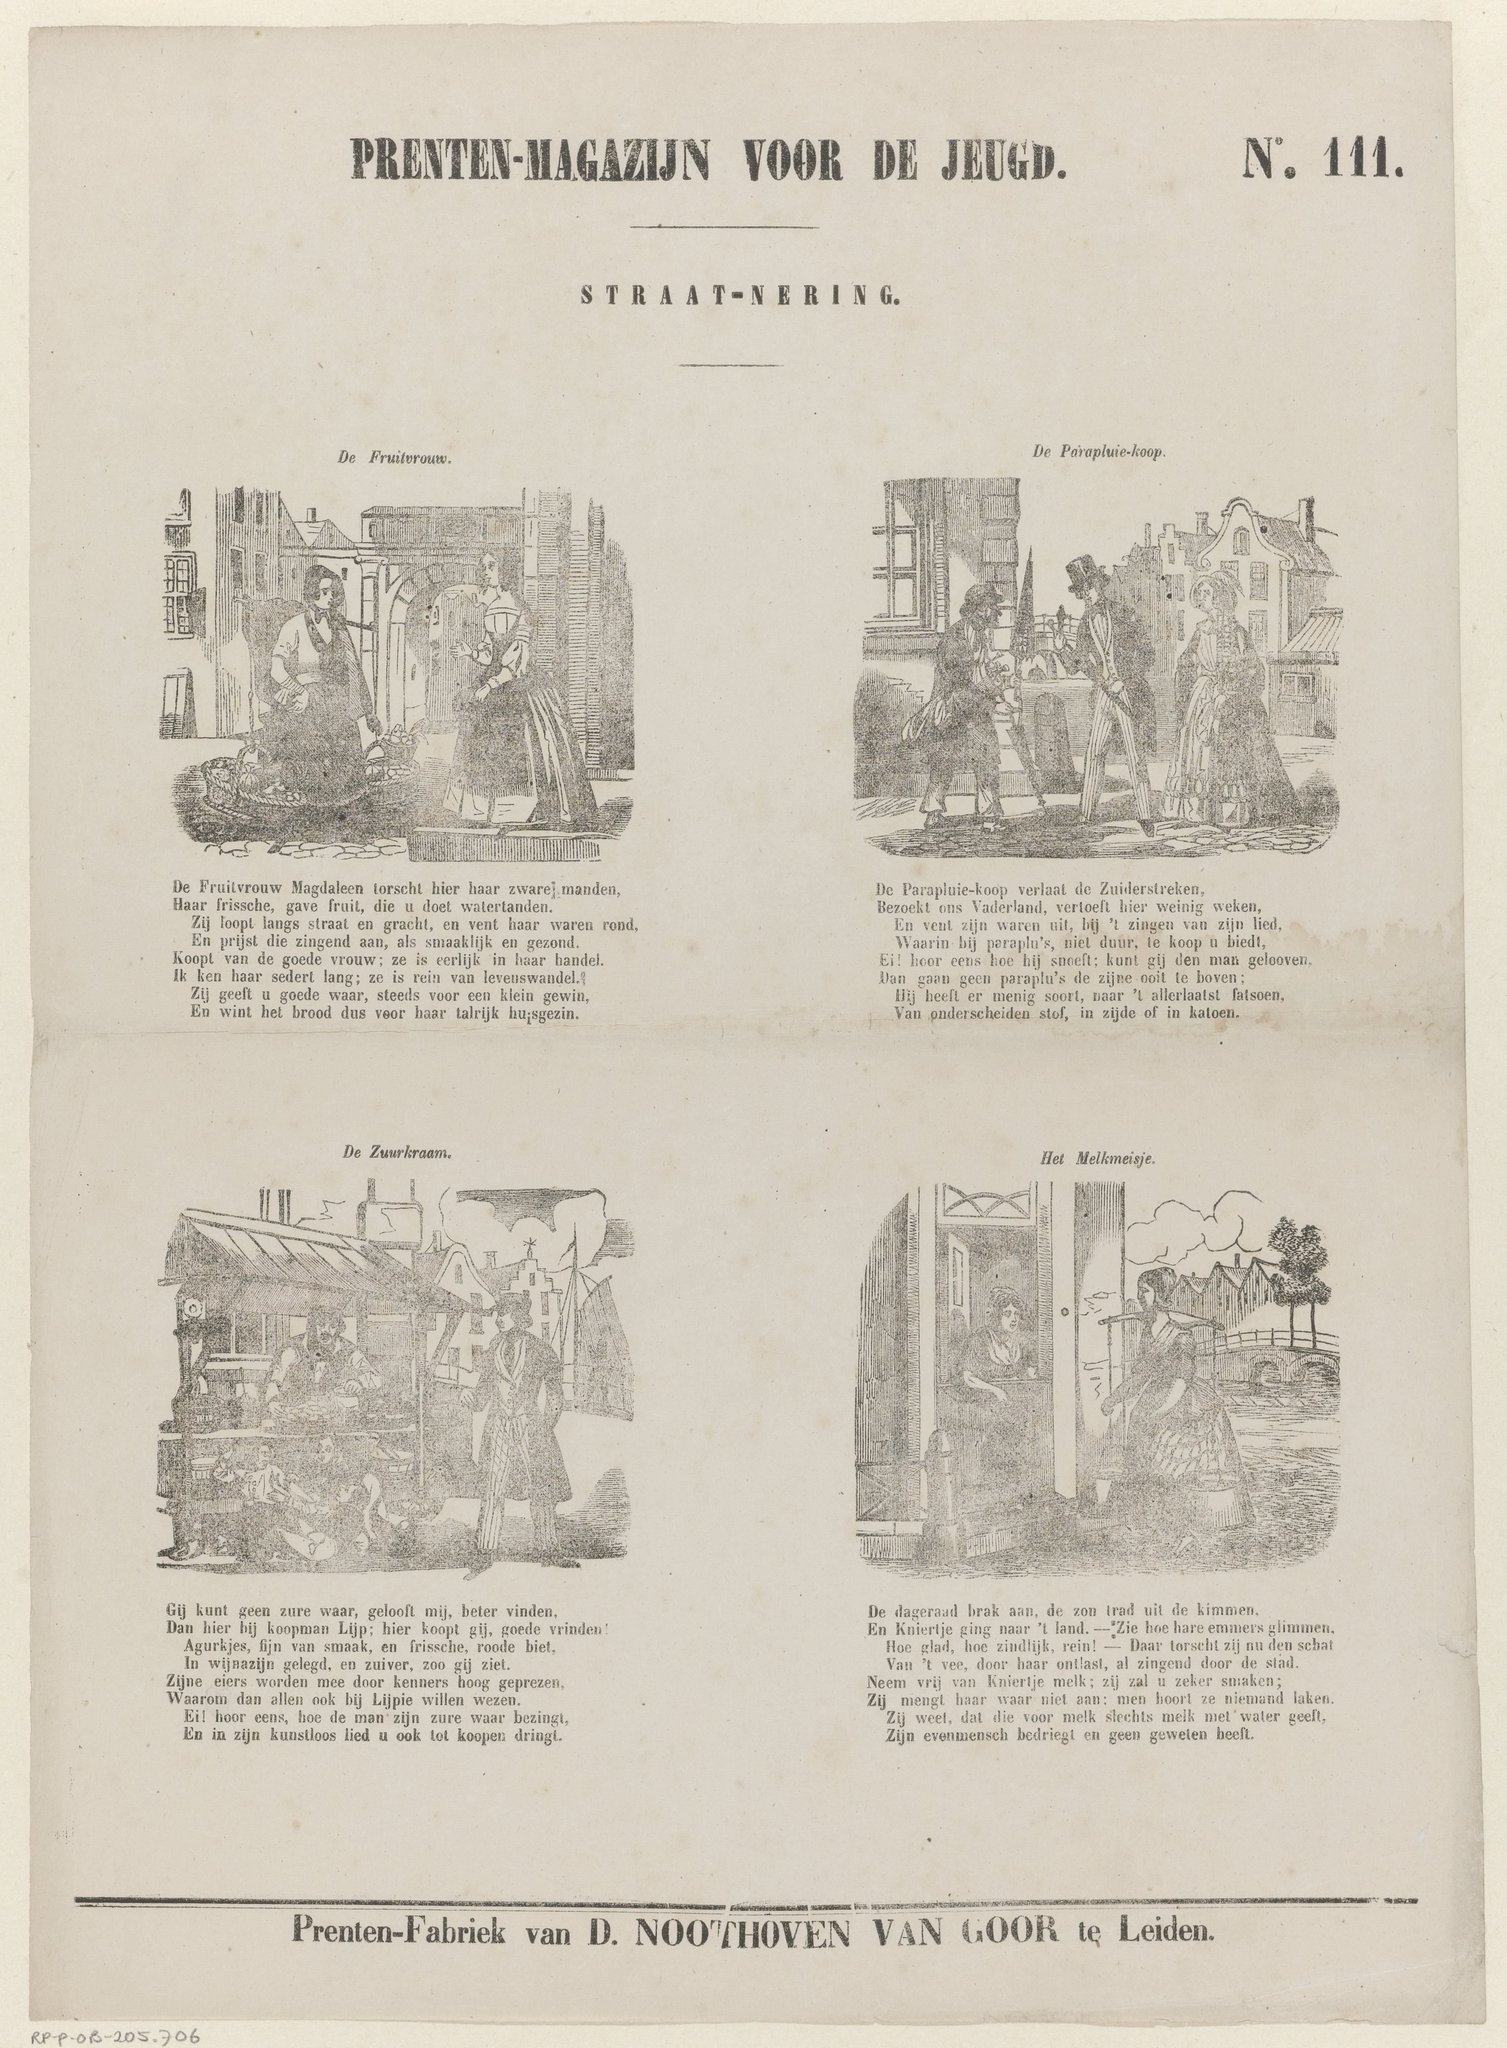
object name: print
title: Straatverkopers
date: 1850-1881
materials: paper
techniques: letterpress printing, engraving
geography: leiden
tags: street-trader, milkmaid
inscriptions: collector's mark: Lugt 2760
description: Blad met 4 voorstellingen van straatverkopers: een fruitverkoopster, een parapluverkoper, een verkoper van zure producten en een melkmeid. Boven elke afbeelding een titel, onder elke afbeelding een achtregelig vers. Genummerd rechtsboven: No. 111.